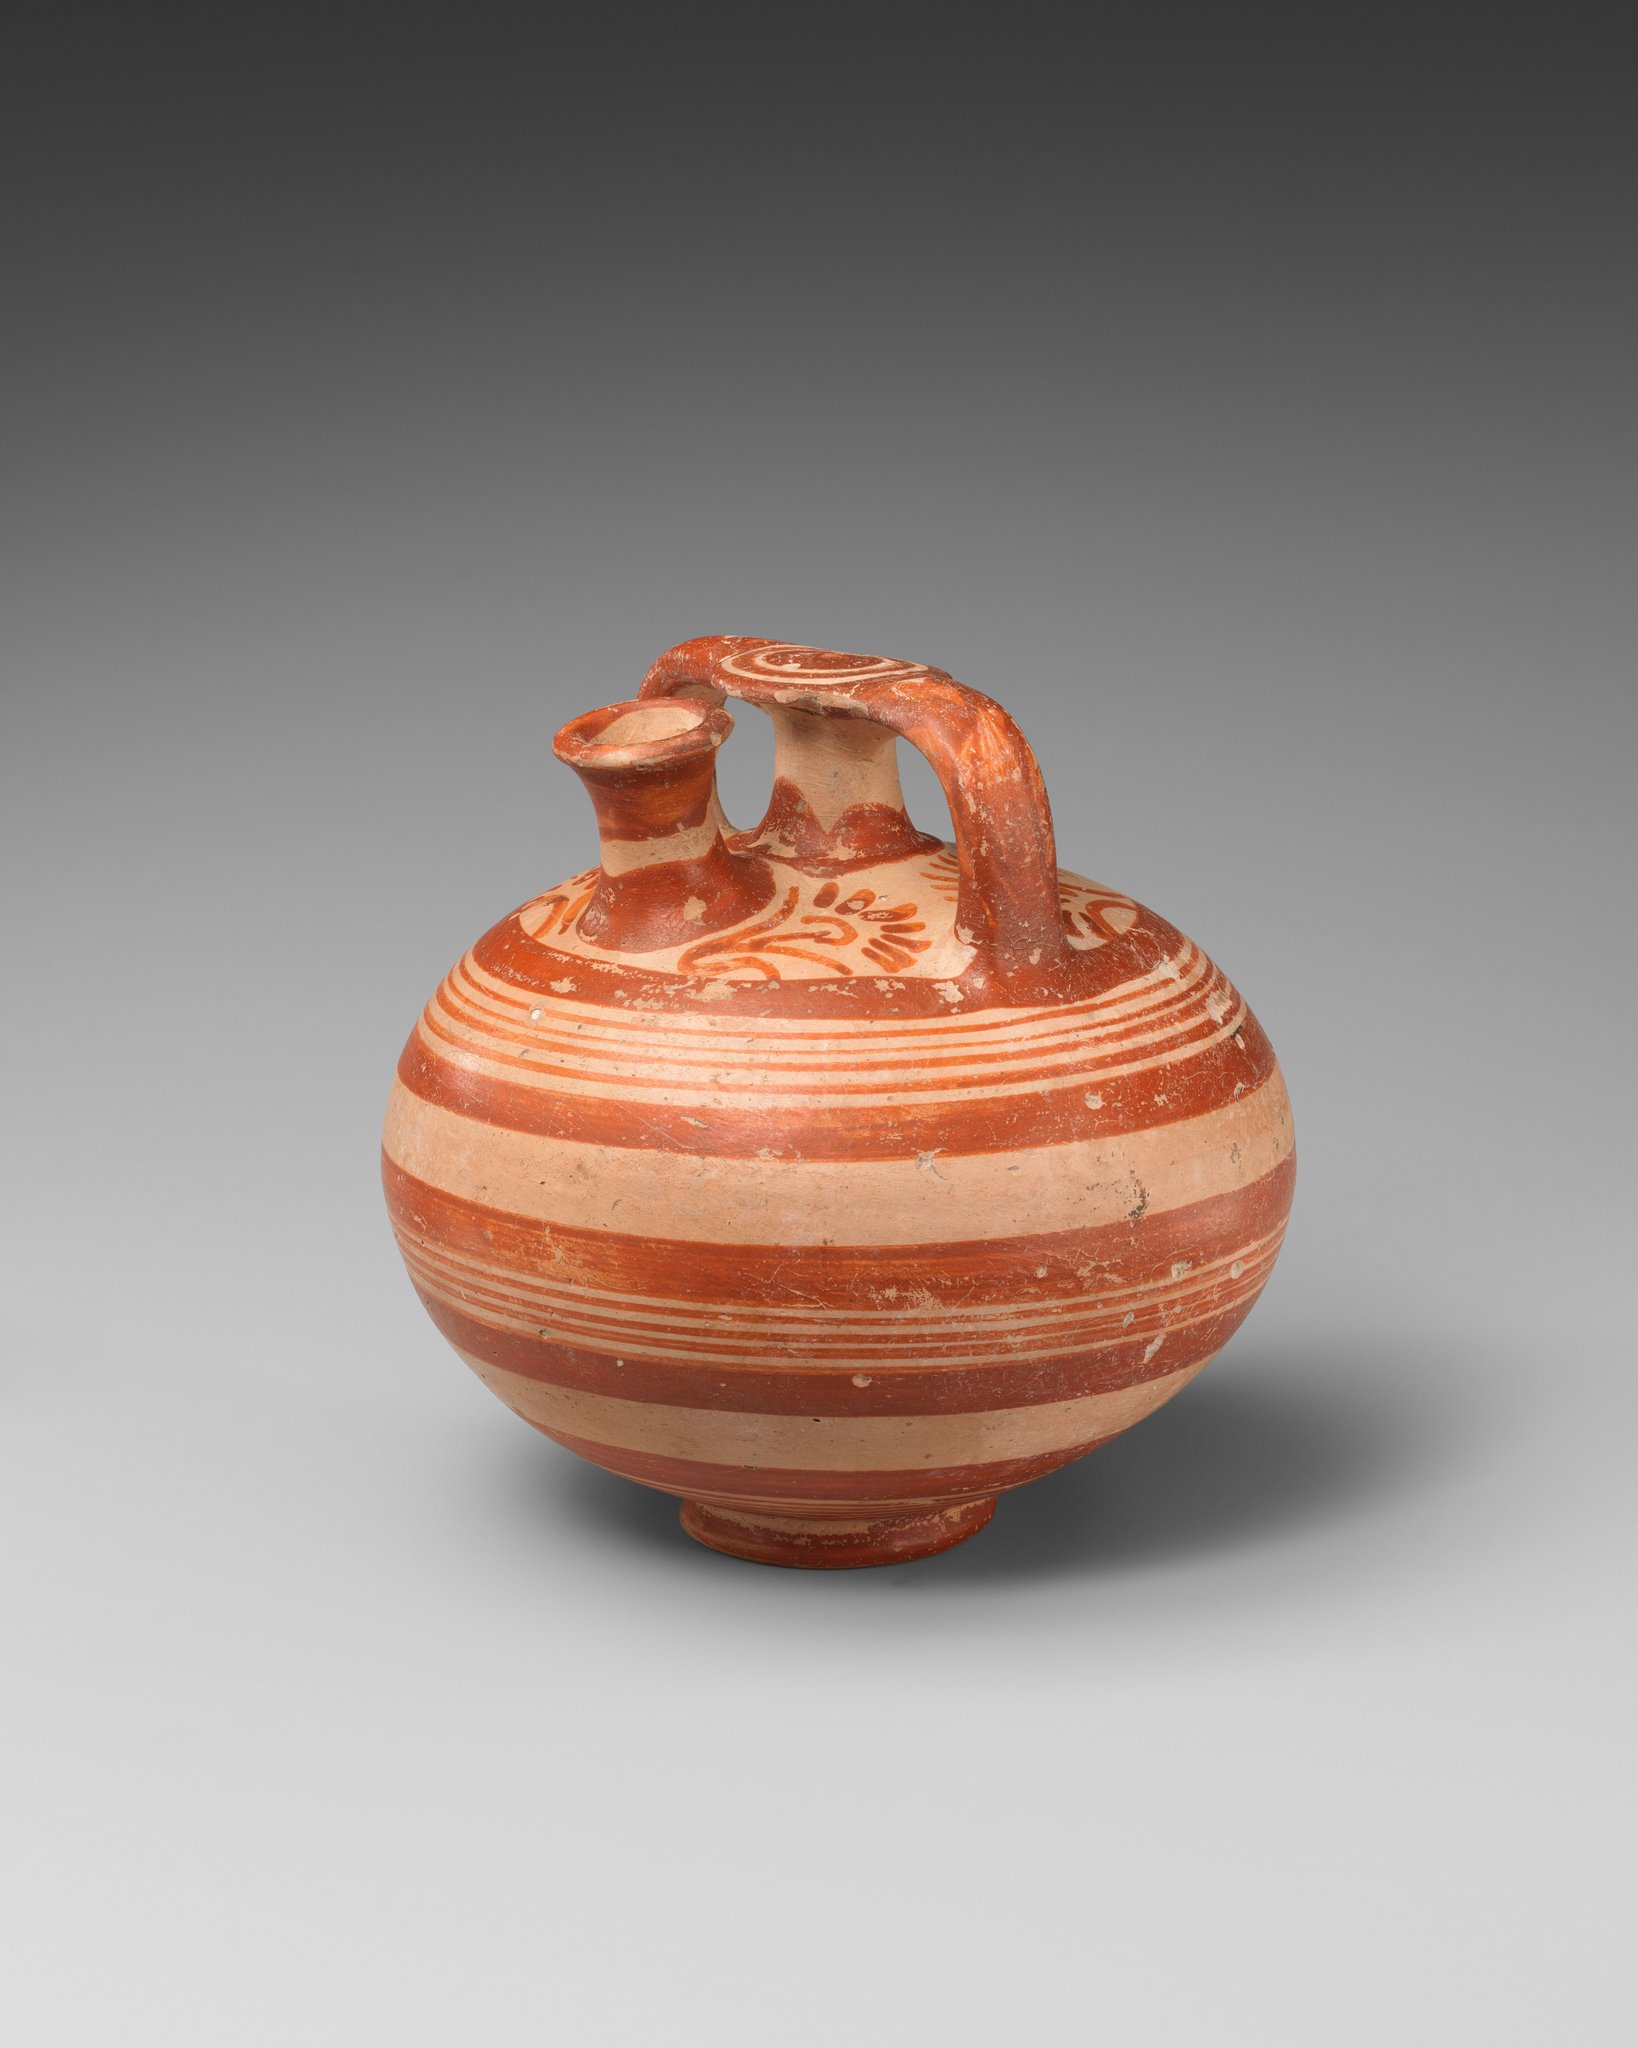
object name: stirrup jar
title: Terracotta stirrup jar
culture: mycenaean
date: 1300-1230 BCE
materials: terracotta